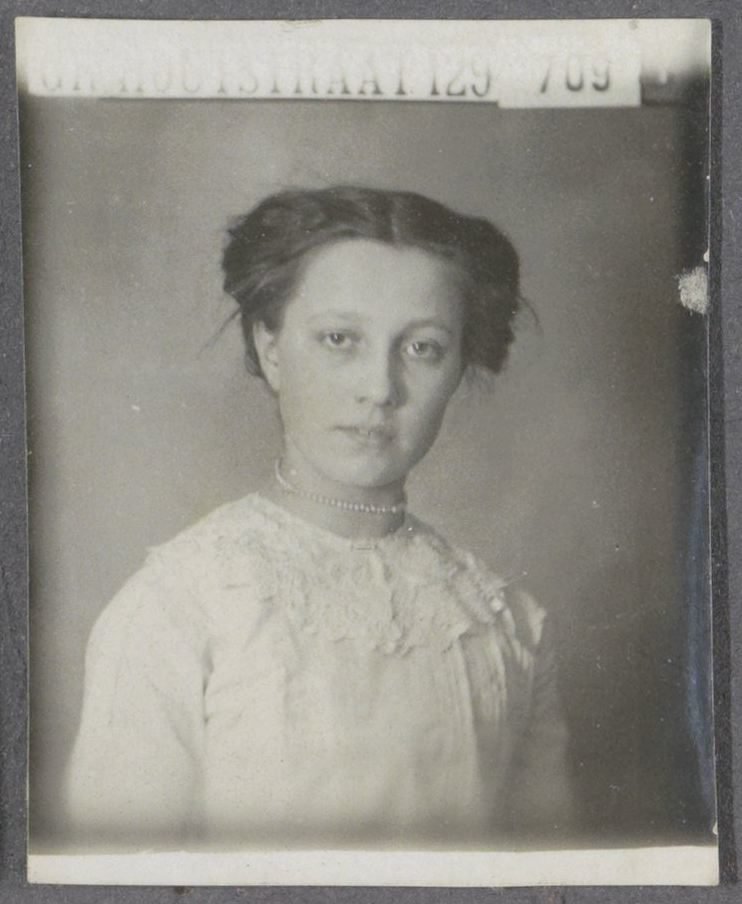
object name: snapshot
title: Portret van een vrouw met opgebonden haar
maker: Anonymous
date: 1920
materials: cardboard, paper, photographic support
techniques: gelatin silver print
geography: netherlands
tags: adult woman, historical persons, styles of hairdress - aa - ~ women, netherlands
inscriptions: number: ‘709’, address: ‘[...]straat 129’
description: Onderdeel van Fotoalbum met portretten vervaardigd door Nederlandse studio's waaronder automaatfoto's.